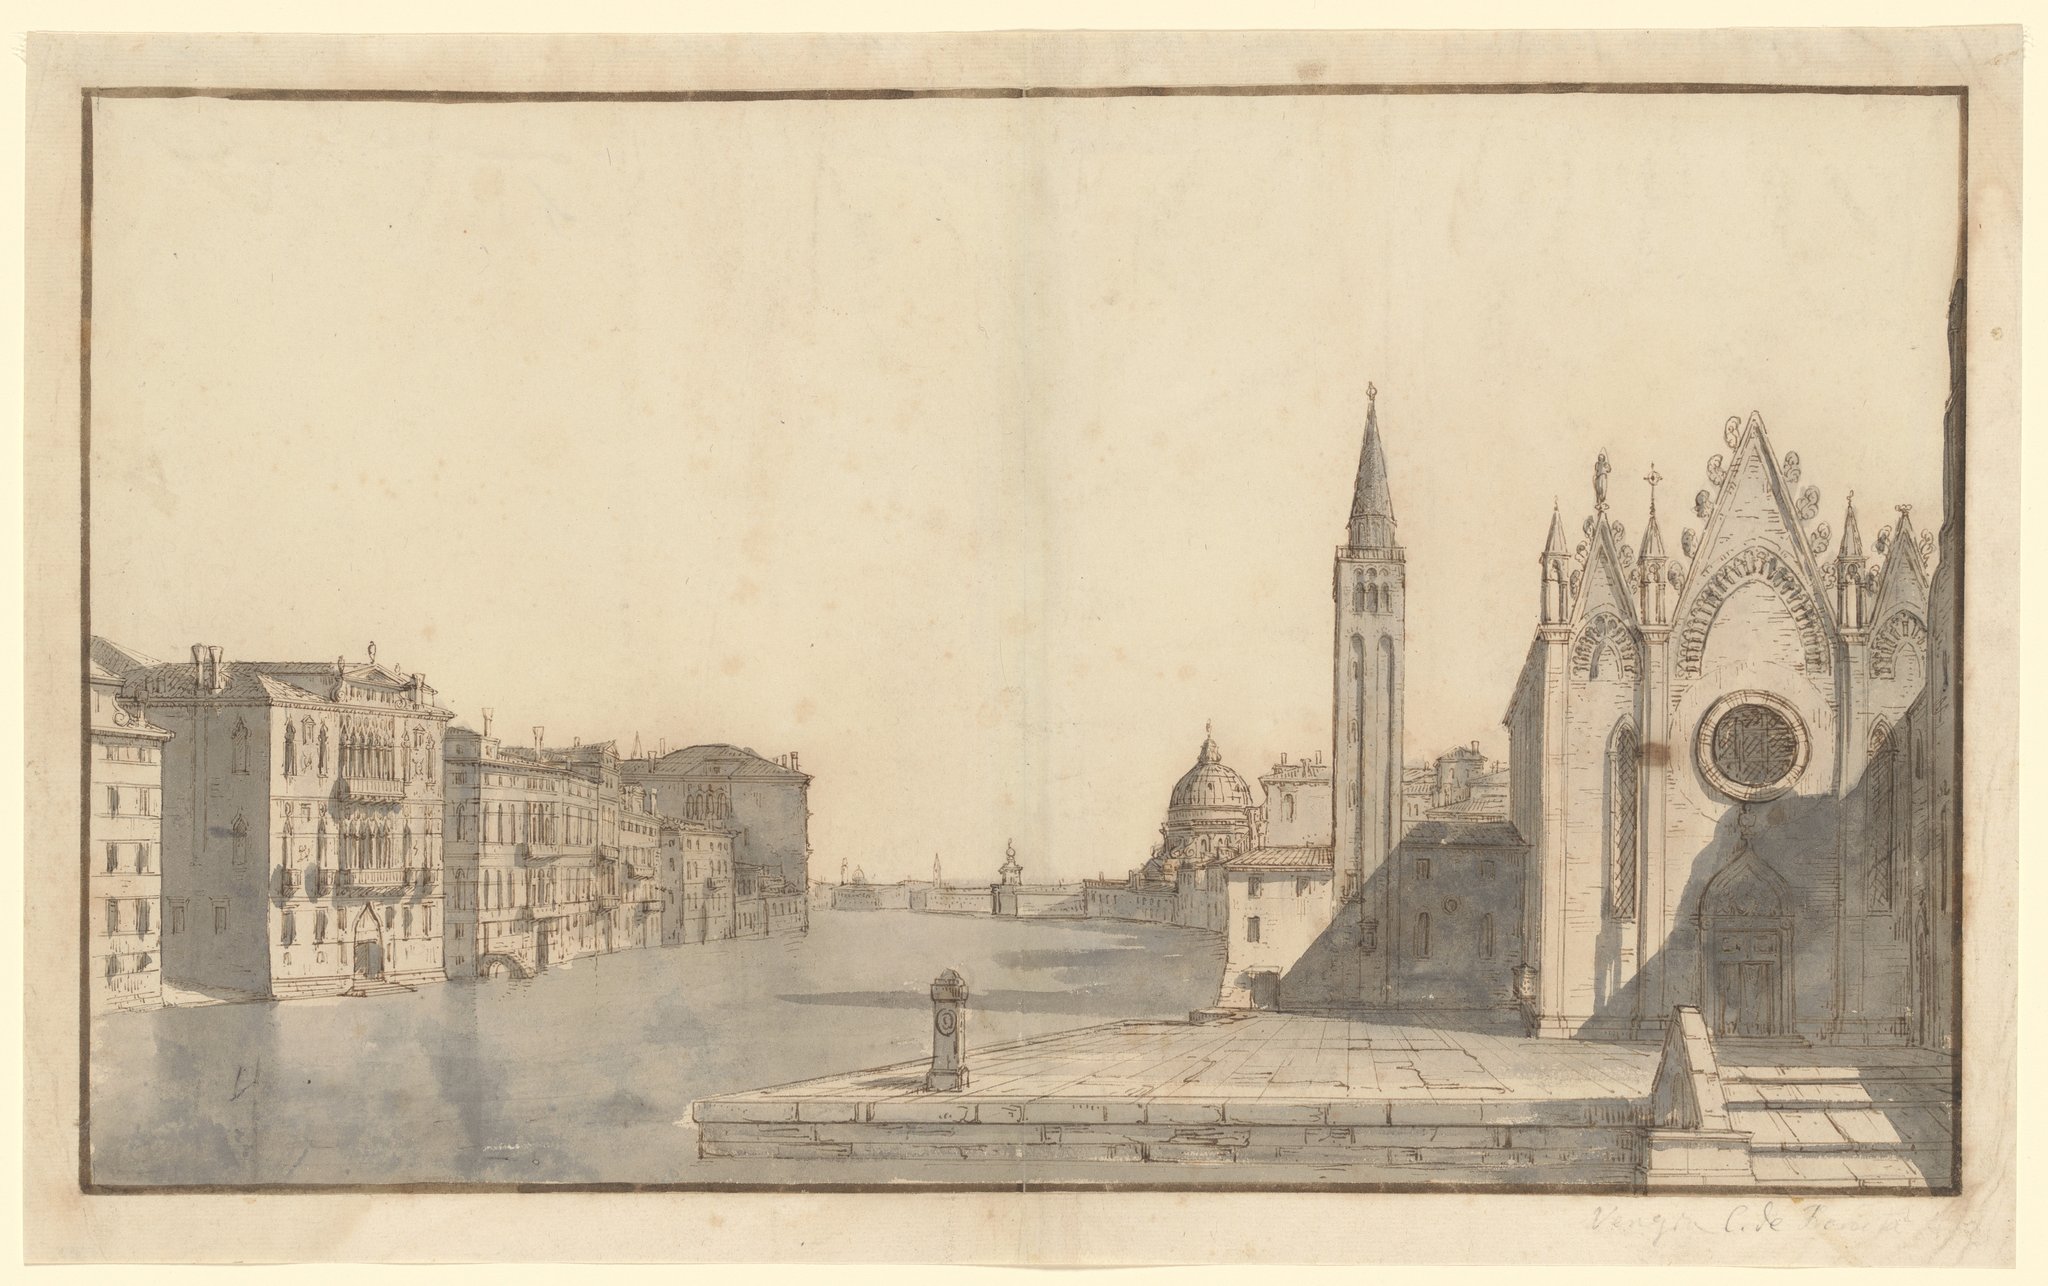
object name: drawing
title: The Grand Canal from the Carità to the Dogana da Mar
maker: bernardo bellotto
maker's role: artist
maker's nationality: italian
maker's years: 1722-1780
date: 1736-1737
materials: ink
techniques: pen, wash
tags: cities,canals